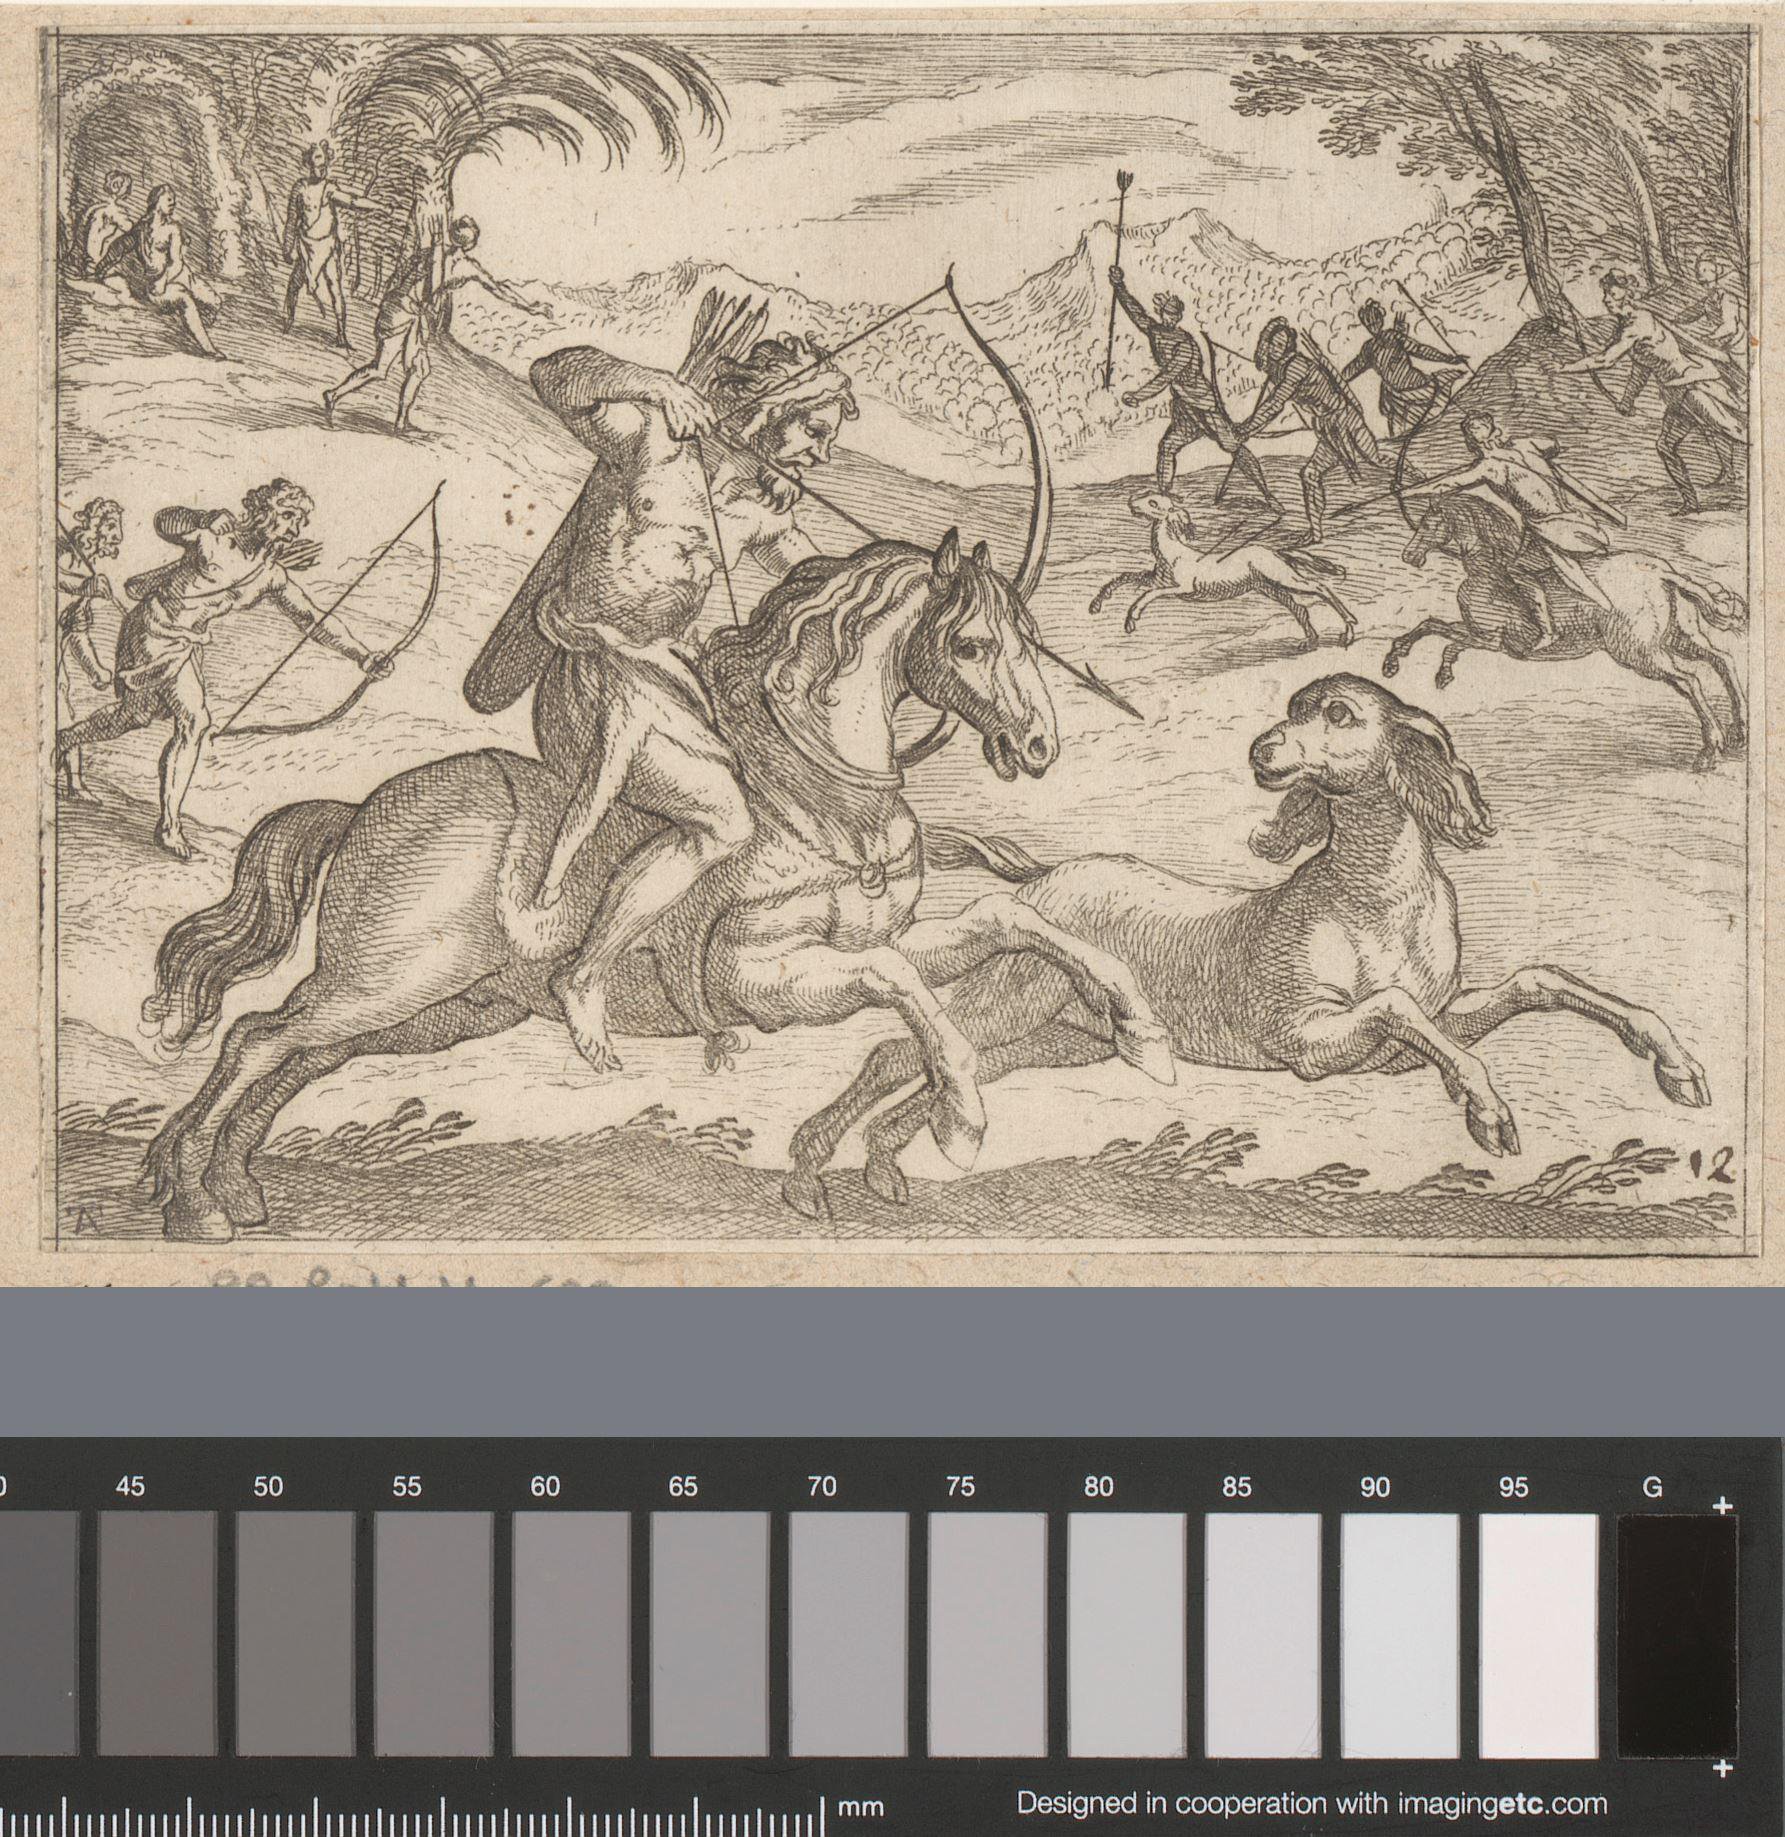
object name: print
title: Primo libro di caccie varie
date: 1598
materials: paper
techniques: etching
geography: italy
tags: hunter, hunters hunting (n.b.: in 1988-1990 this notation denoted the concept of 43c11421 'hunters resting during the hunt'), hunt ~ mammals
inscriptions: collector's mark: Lugt 11, number: ‘12’, collector's mark: ‘Hinloopen’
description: Een landschap met primitieve jagers in lendendoeken jagend op wilde honden (de dieren lijken meer op lama's met hangoren).